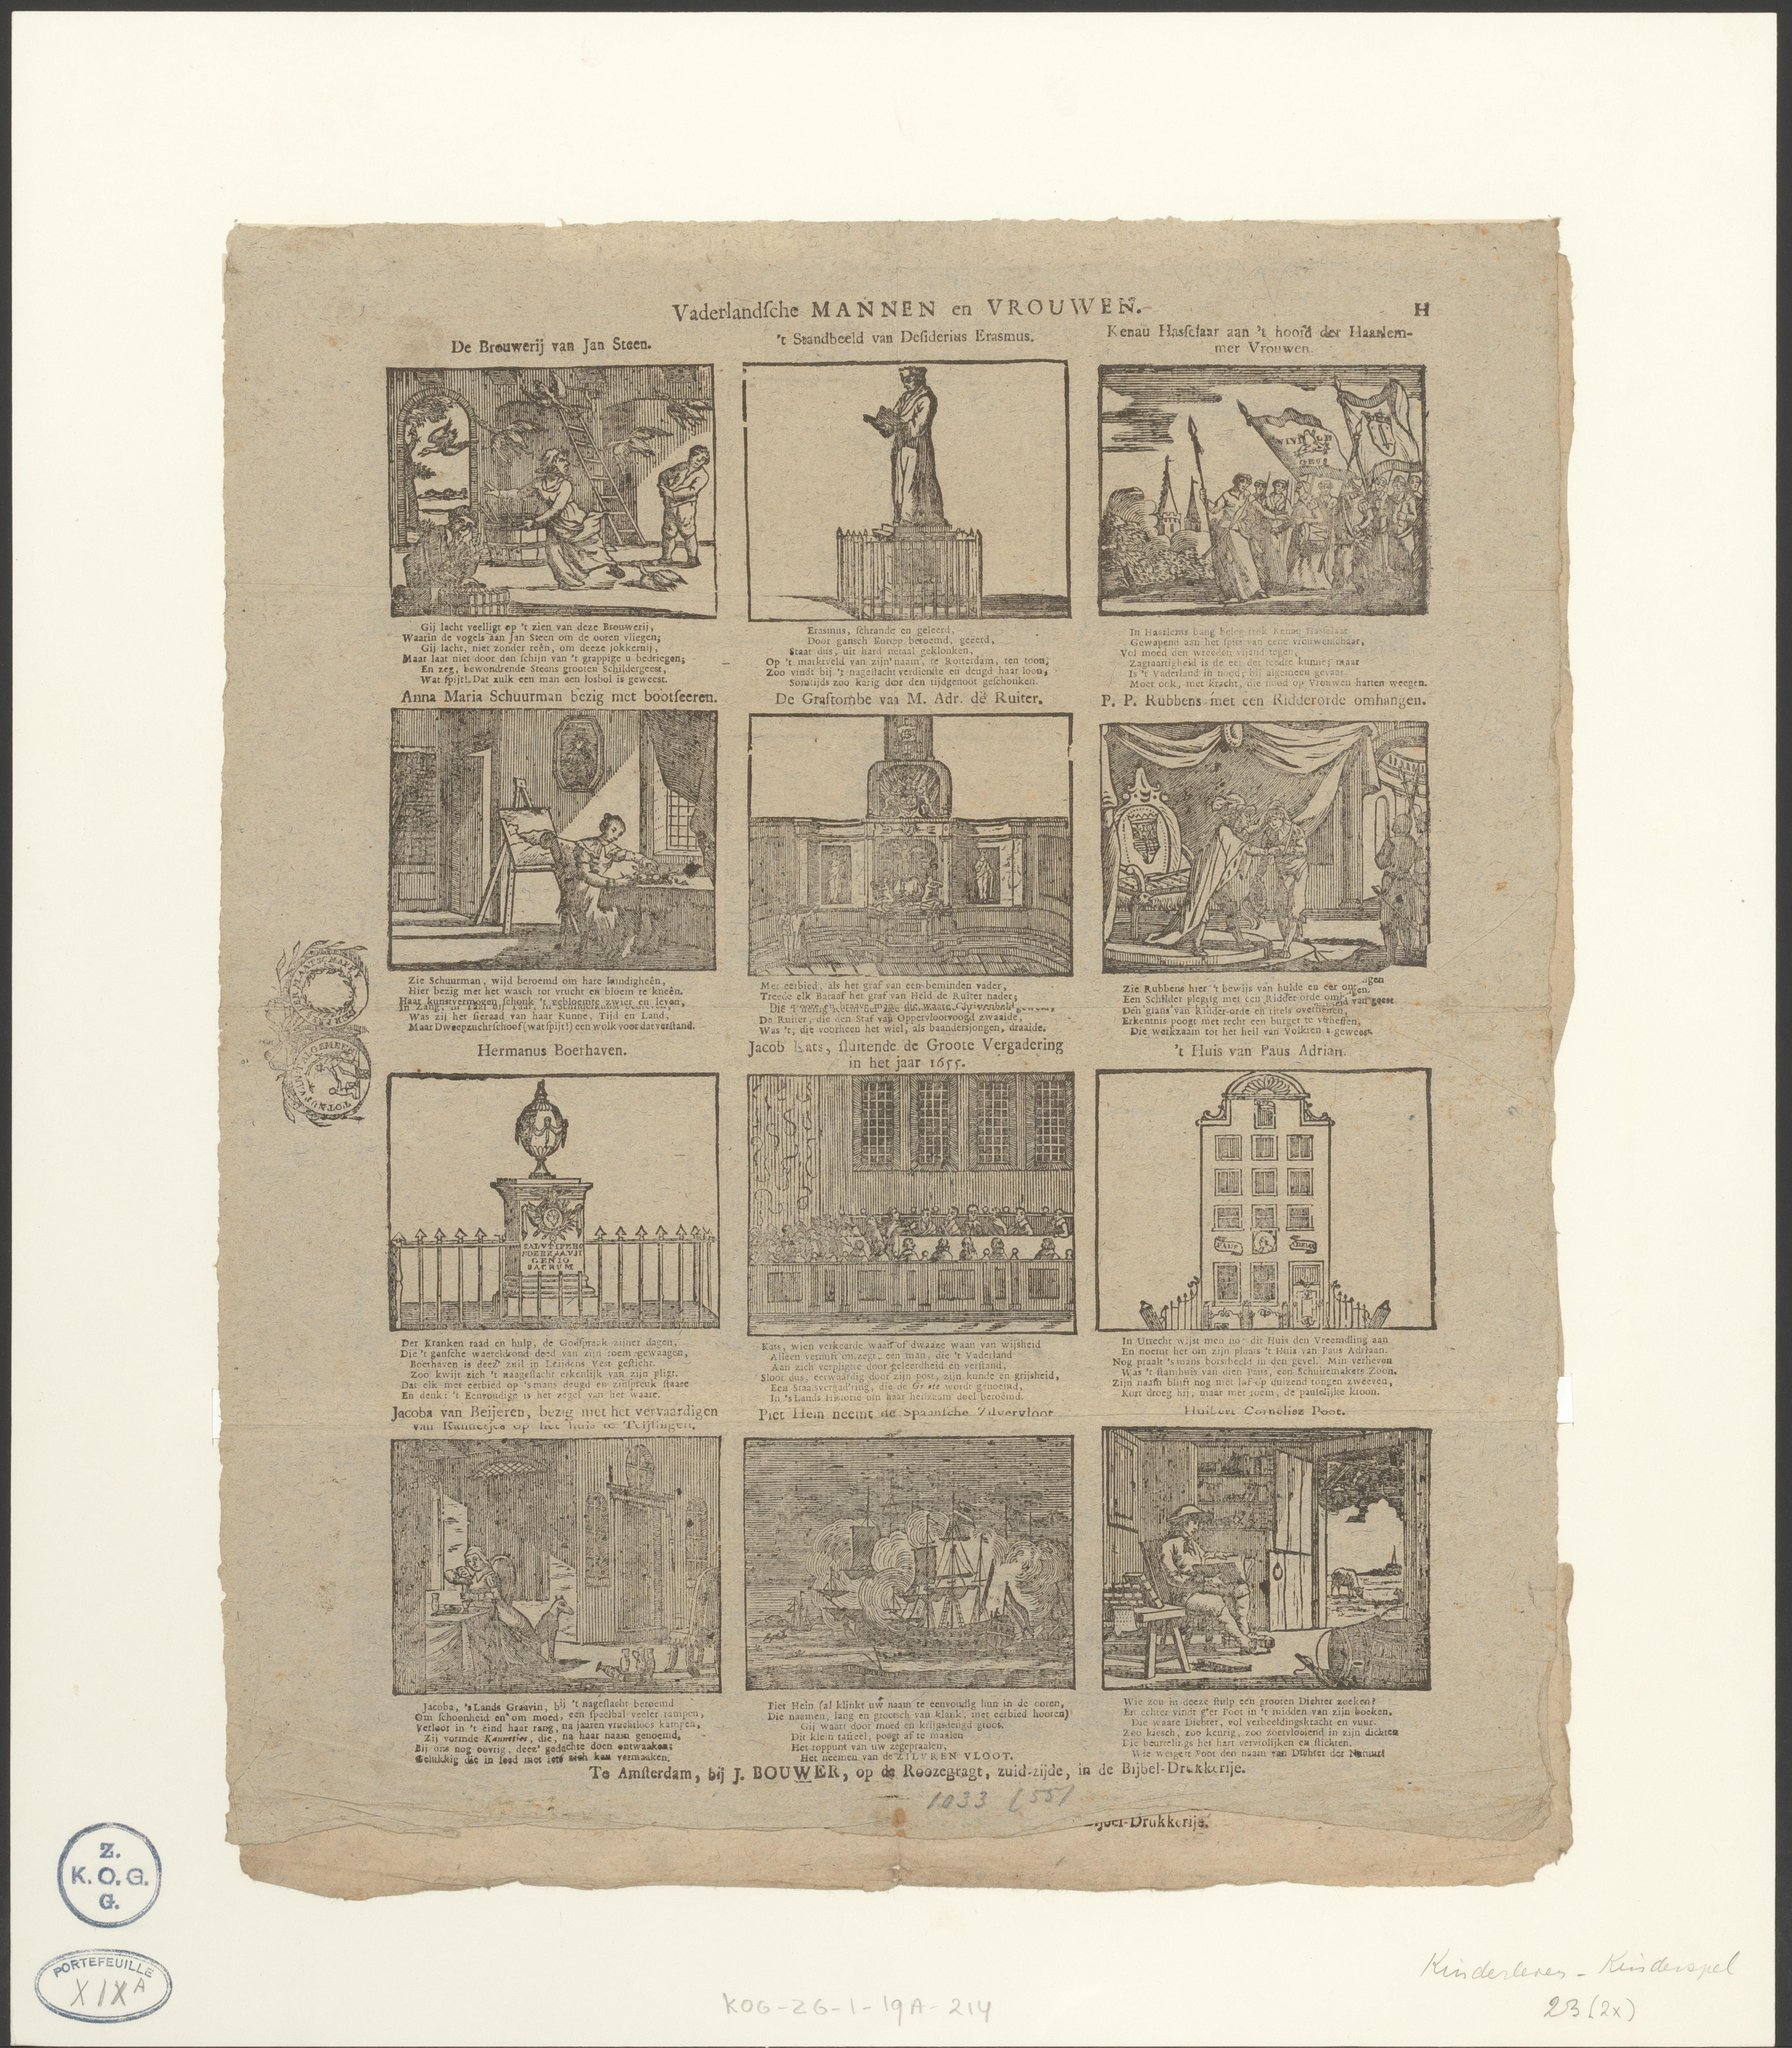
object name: print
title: Vaderlandsche mannen en vrouwen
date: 1805-1808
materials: paper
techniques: letterpress printing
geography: amsterdam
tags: cologne, anna maria van schurman, leiden, jan havicksz. steen, jacoba of bavaria (countess of hainaut), rotterdam, desiderius erasmus, flushing, michiel adriaenszoon de ruyter, delfshaven, the hague, jacob cats (1577-1660), delft, hubert kornelisz. poot, antwerp, painter, print maker, draughtsman, peter paul rubens, utrecht, clergyman, hermanus boerhaave, historical persons - bb - woman, historical persons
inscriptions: stamp, collector's mark: Lugt 1641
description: Blad met twaalf voorstellingen van of over beroemde Nederlandse mannen en vrouwen, historische figuren. Boven elke afbeelding een titel, onder elke afbeelding een zesregelig vers. Genummerd rechtsboven: H. Onderwerpsrubrieken binnen de Atlas Zeden en Gewoonten: Zeden en Gewoonten in Engeren Zin, Des menschen beging, midden en einde, Kinderleven – Kinderspel en Kinderprenten.